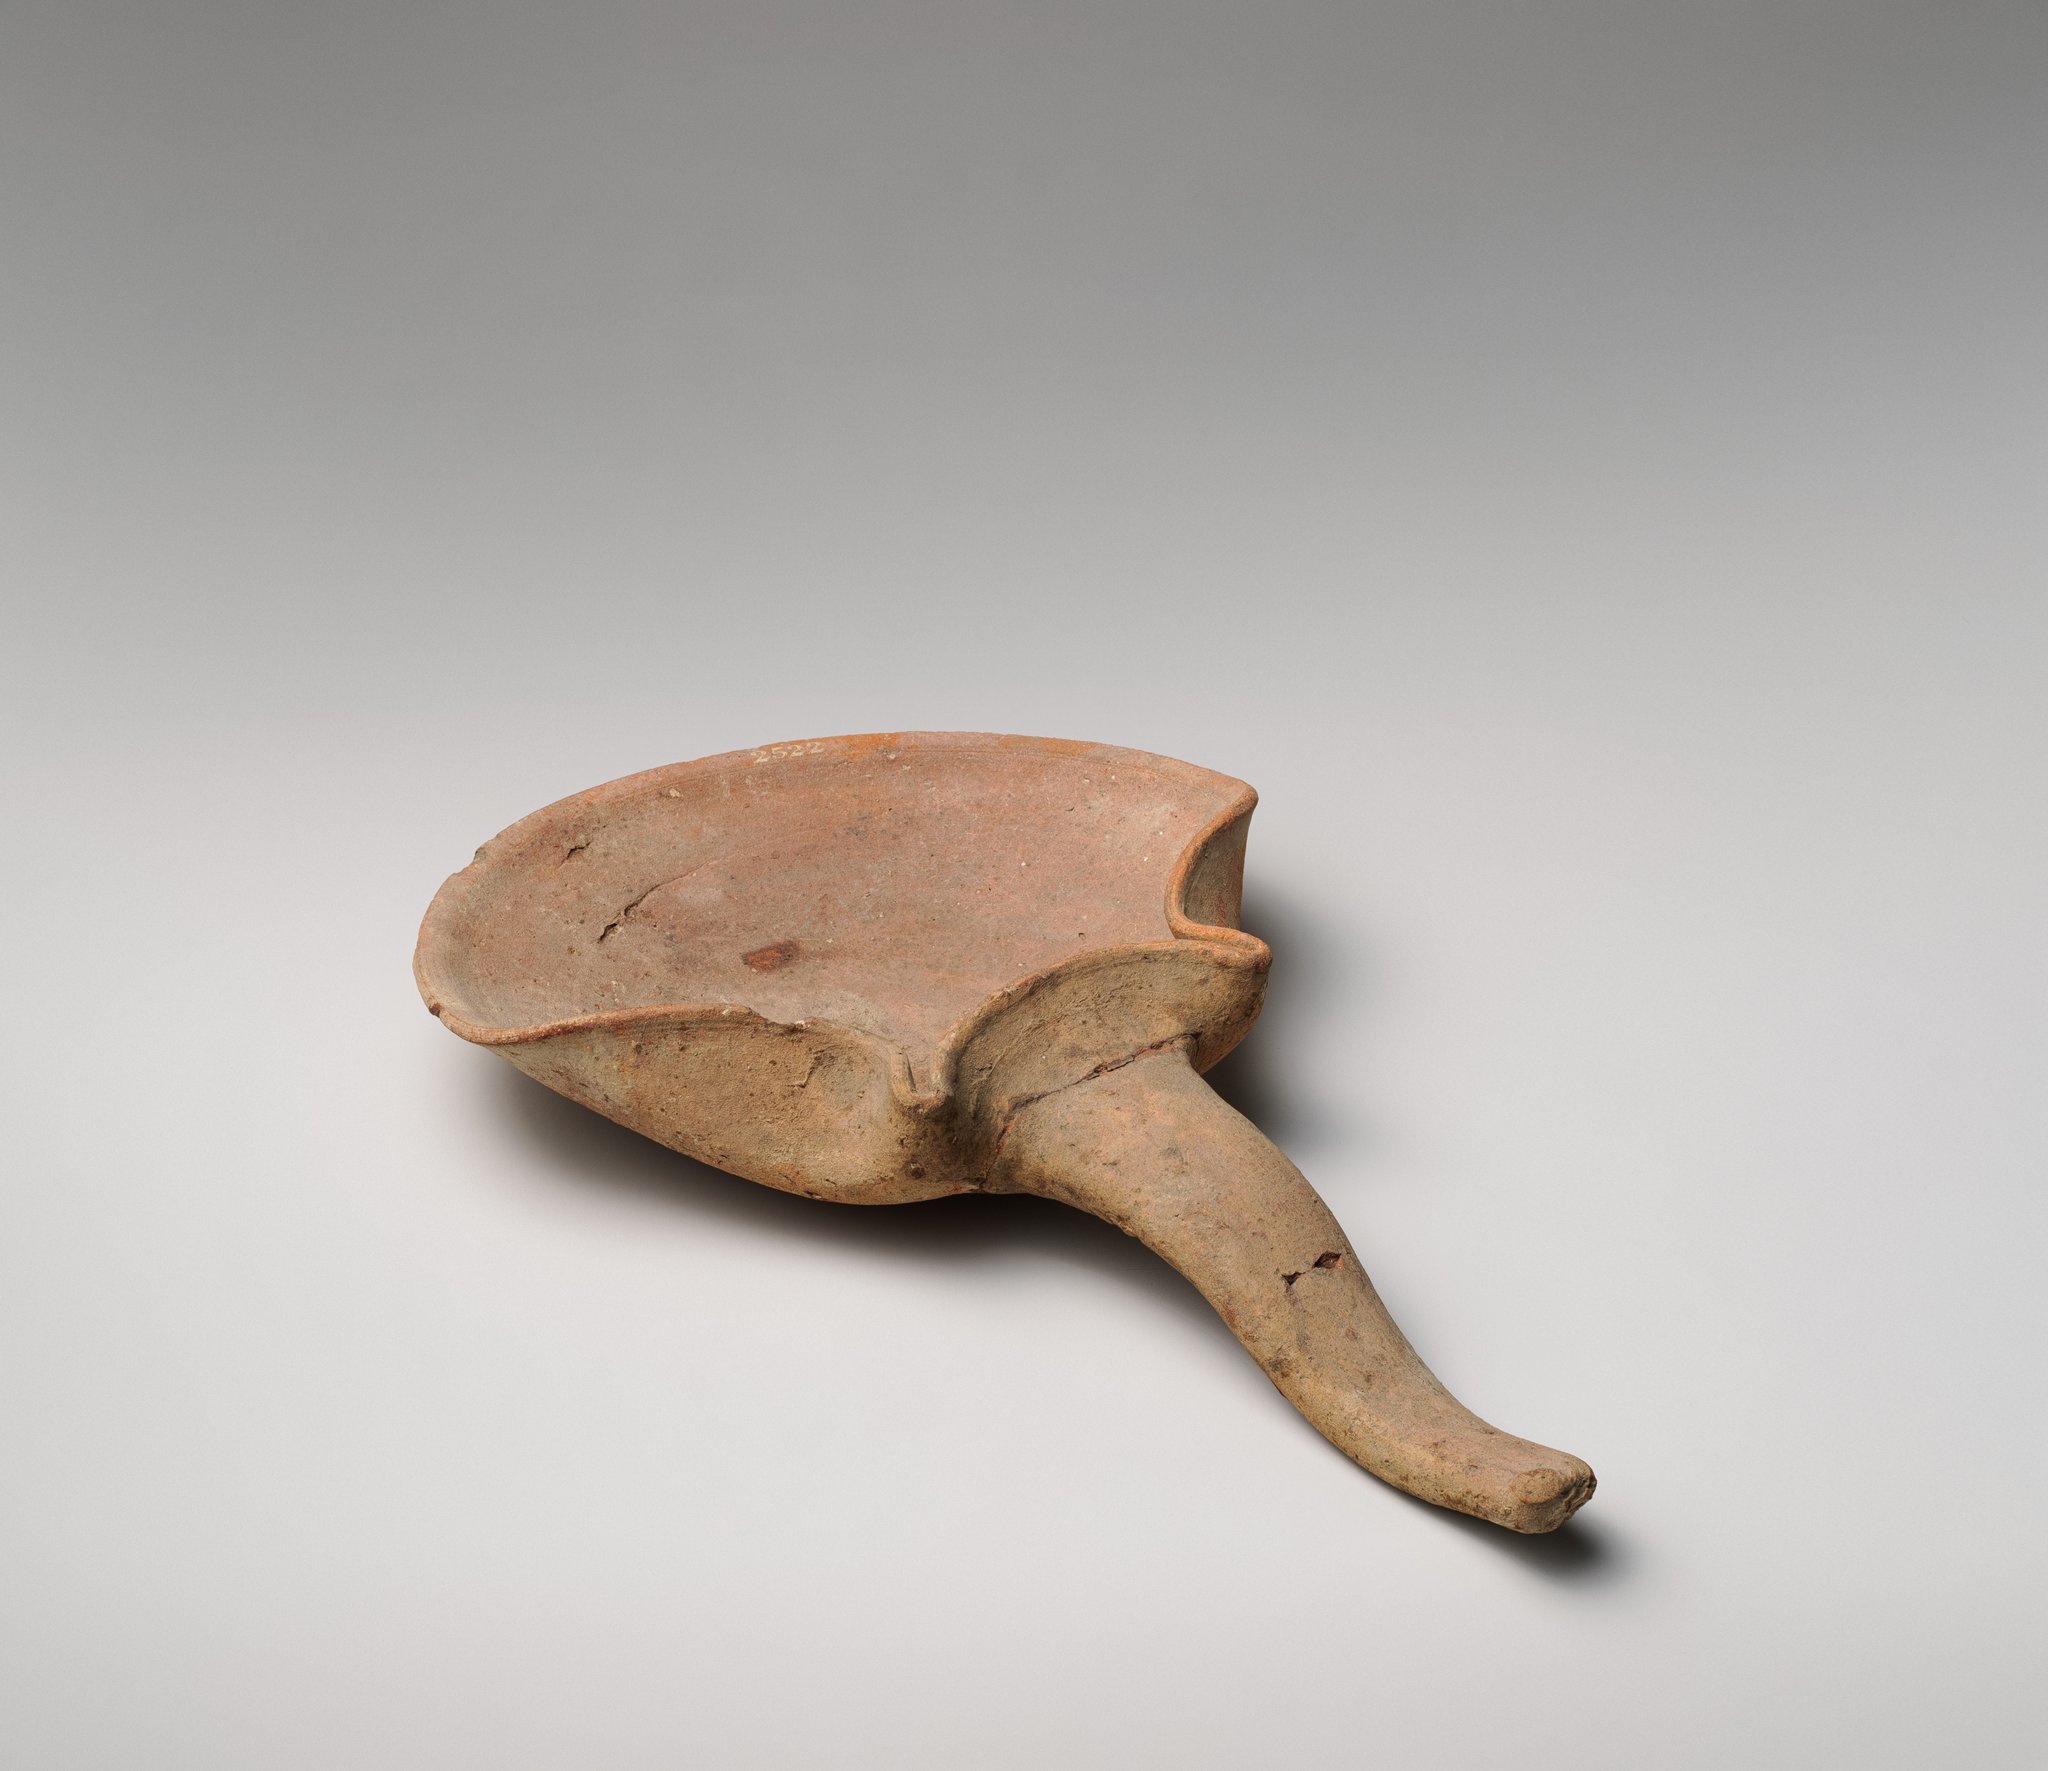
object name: lamp, saucer, handled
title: Terracotta handled saucer-shaped oil lamp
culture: cypriot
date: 400-301 BCE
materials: terracotta